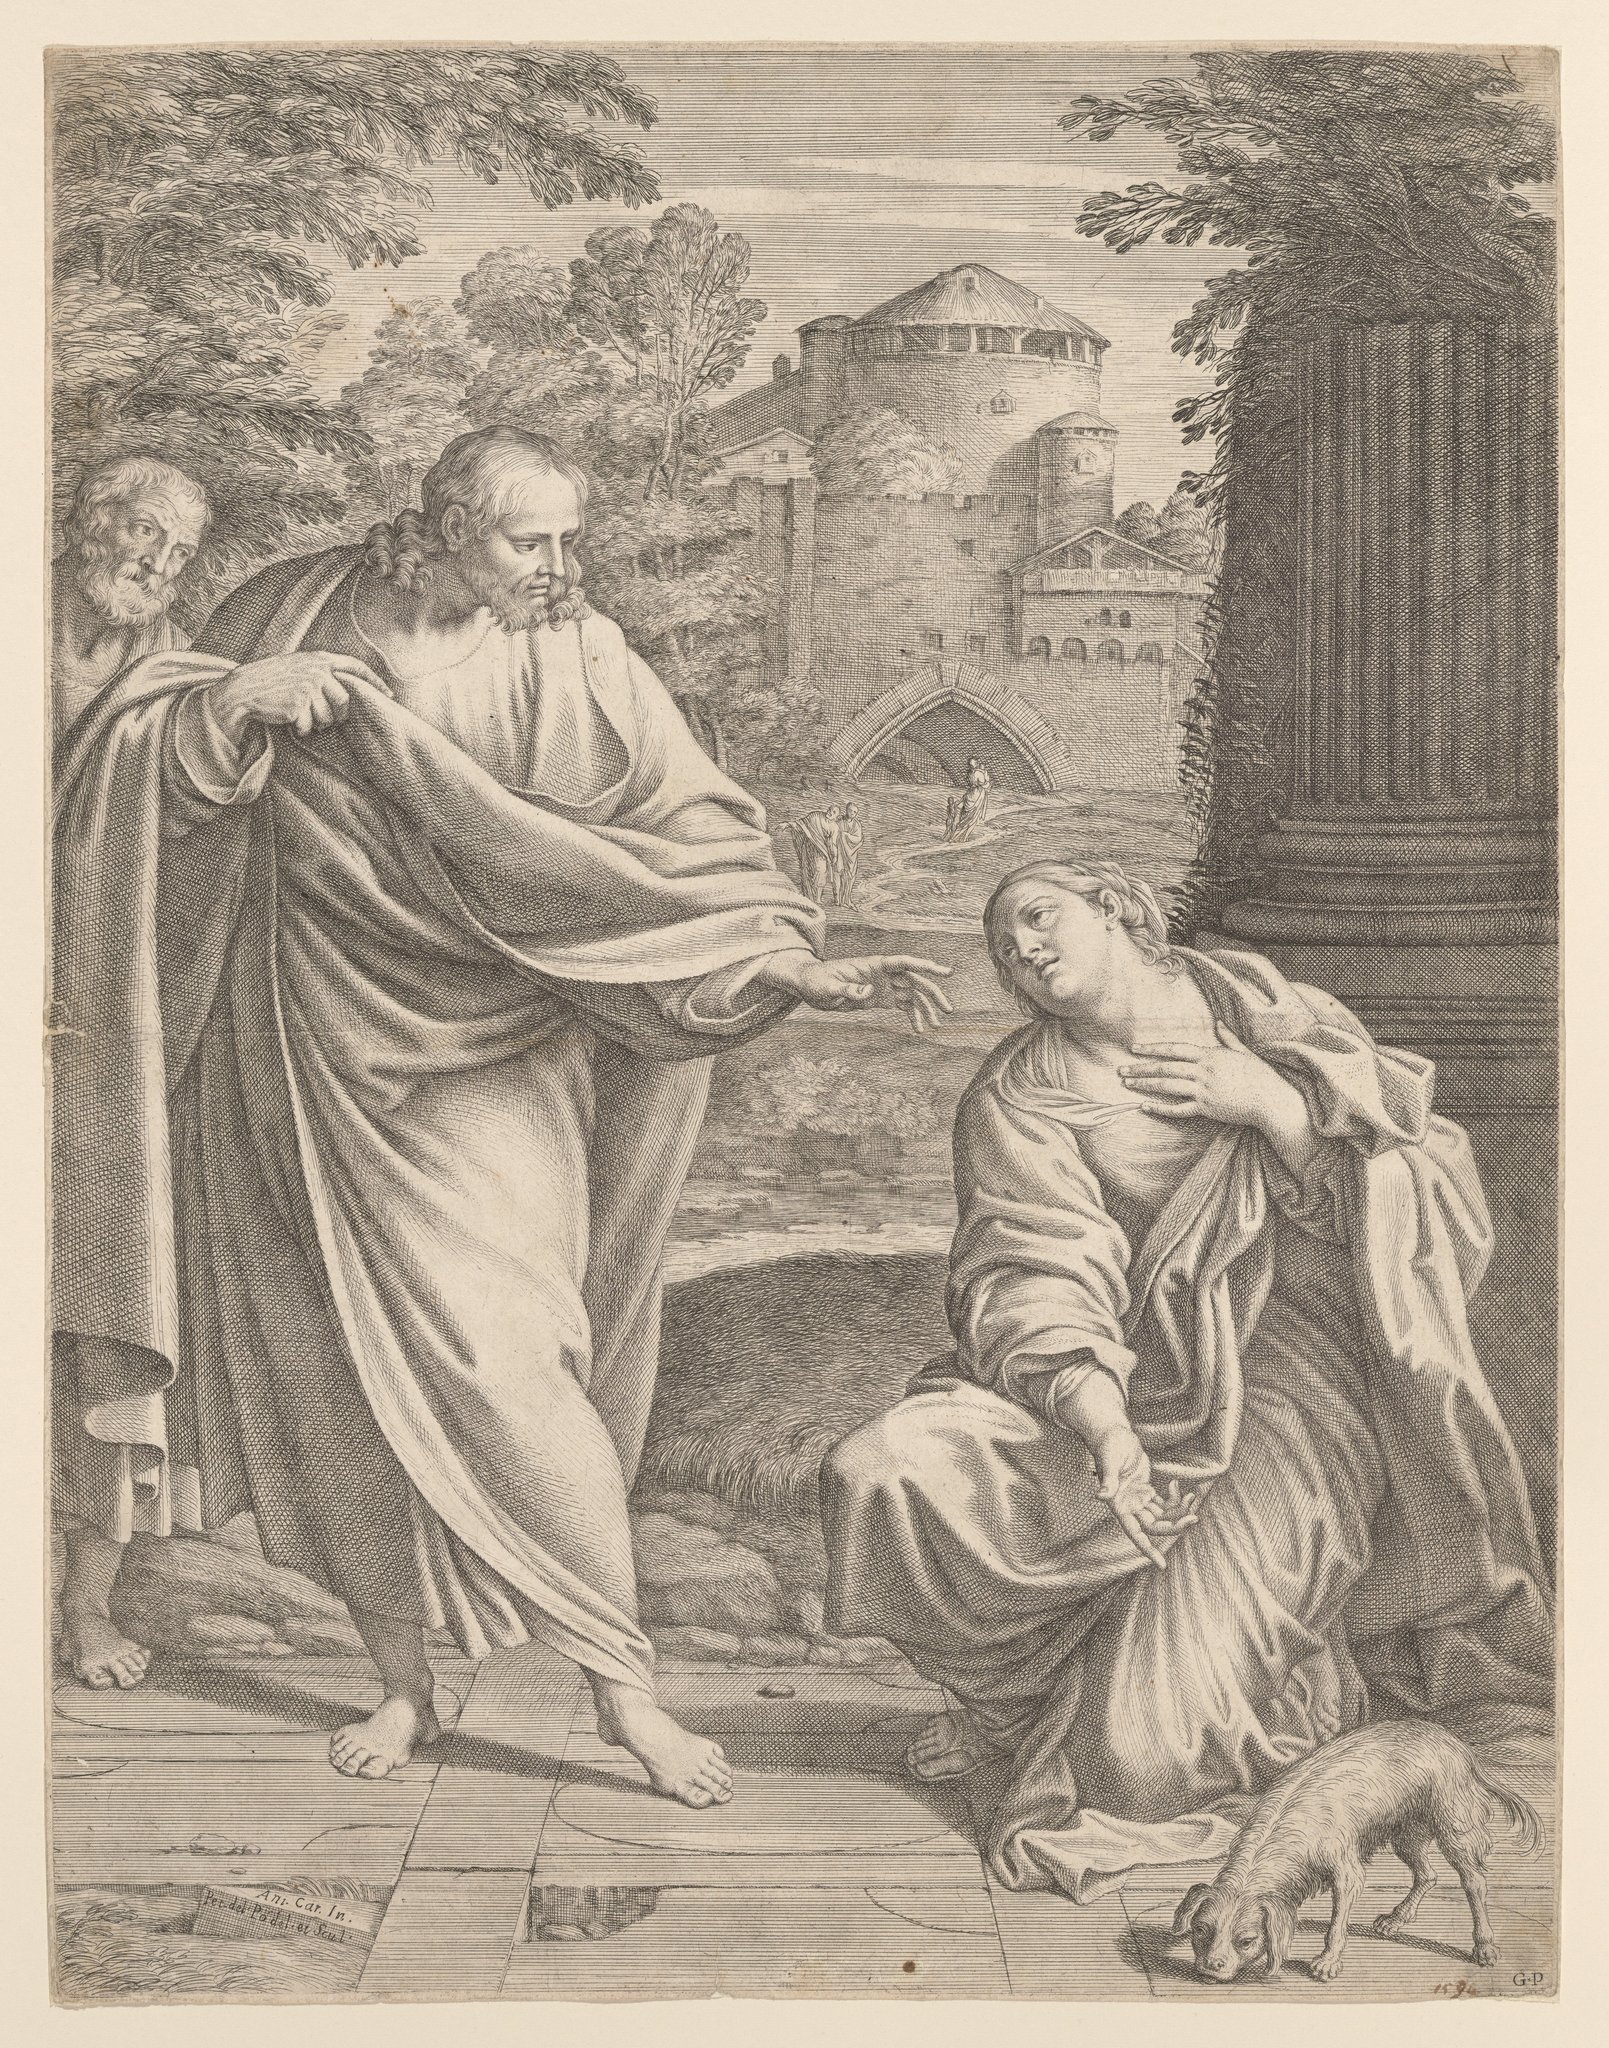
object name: print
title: Christ and the woman of Canaan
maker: pietro del po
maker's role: artist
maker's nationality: italian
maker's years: 1610-1692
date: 1650-1690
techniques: etching